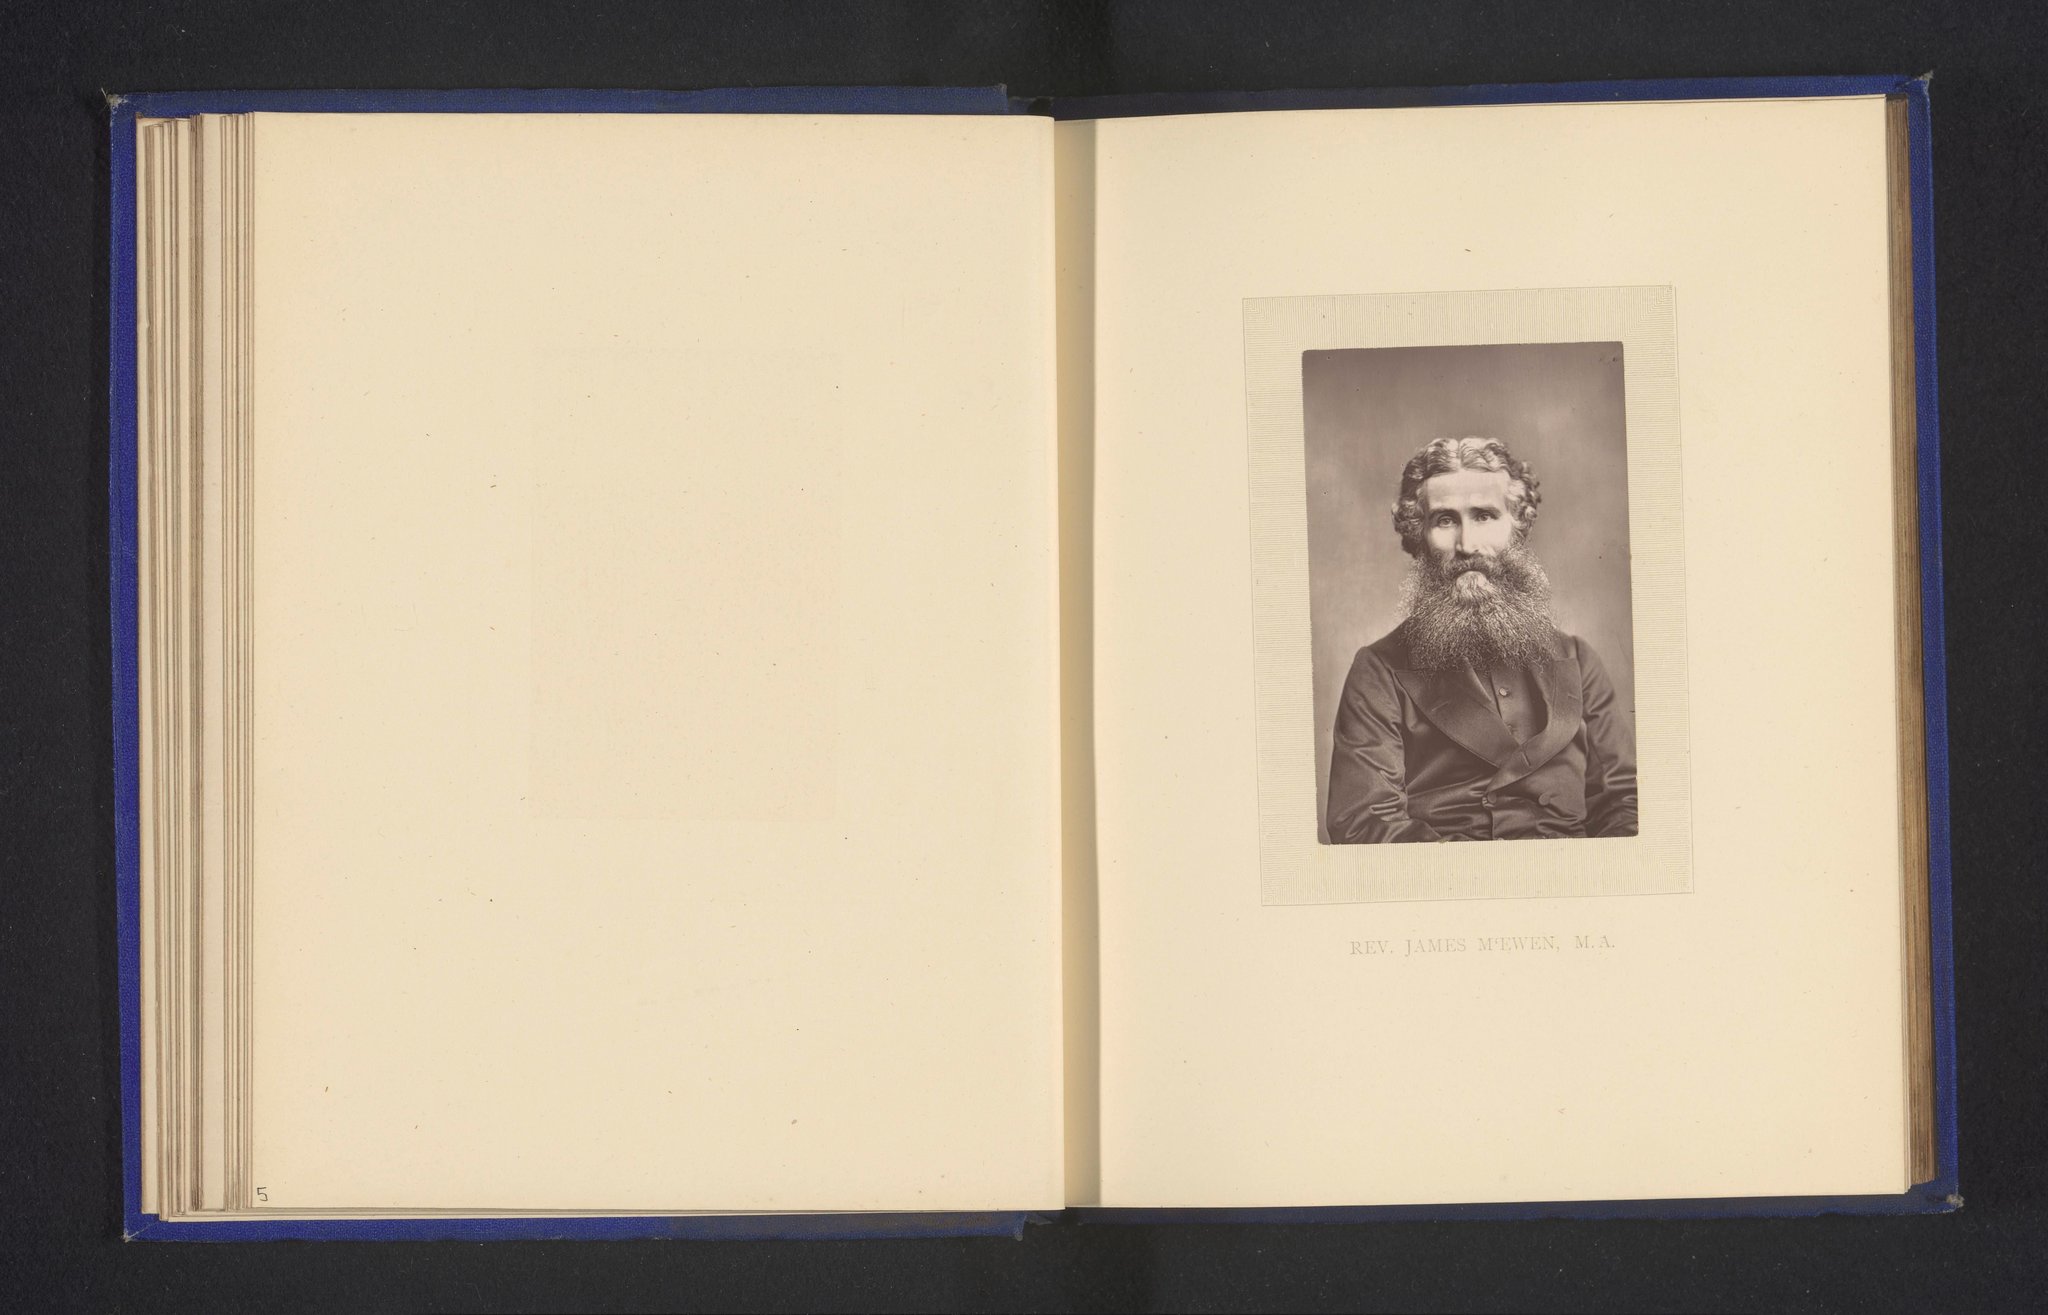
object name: page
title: Portret van James McEwen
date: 1865-1875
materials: paper, photographic support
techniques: carbon print, woodburytype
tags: clergyman, functionaries and dignitaries (with name) ~ protestant churches